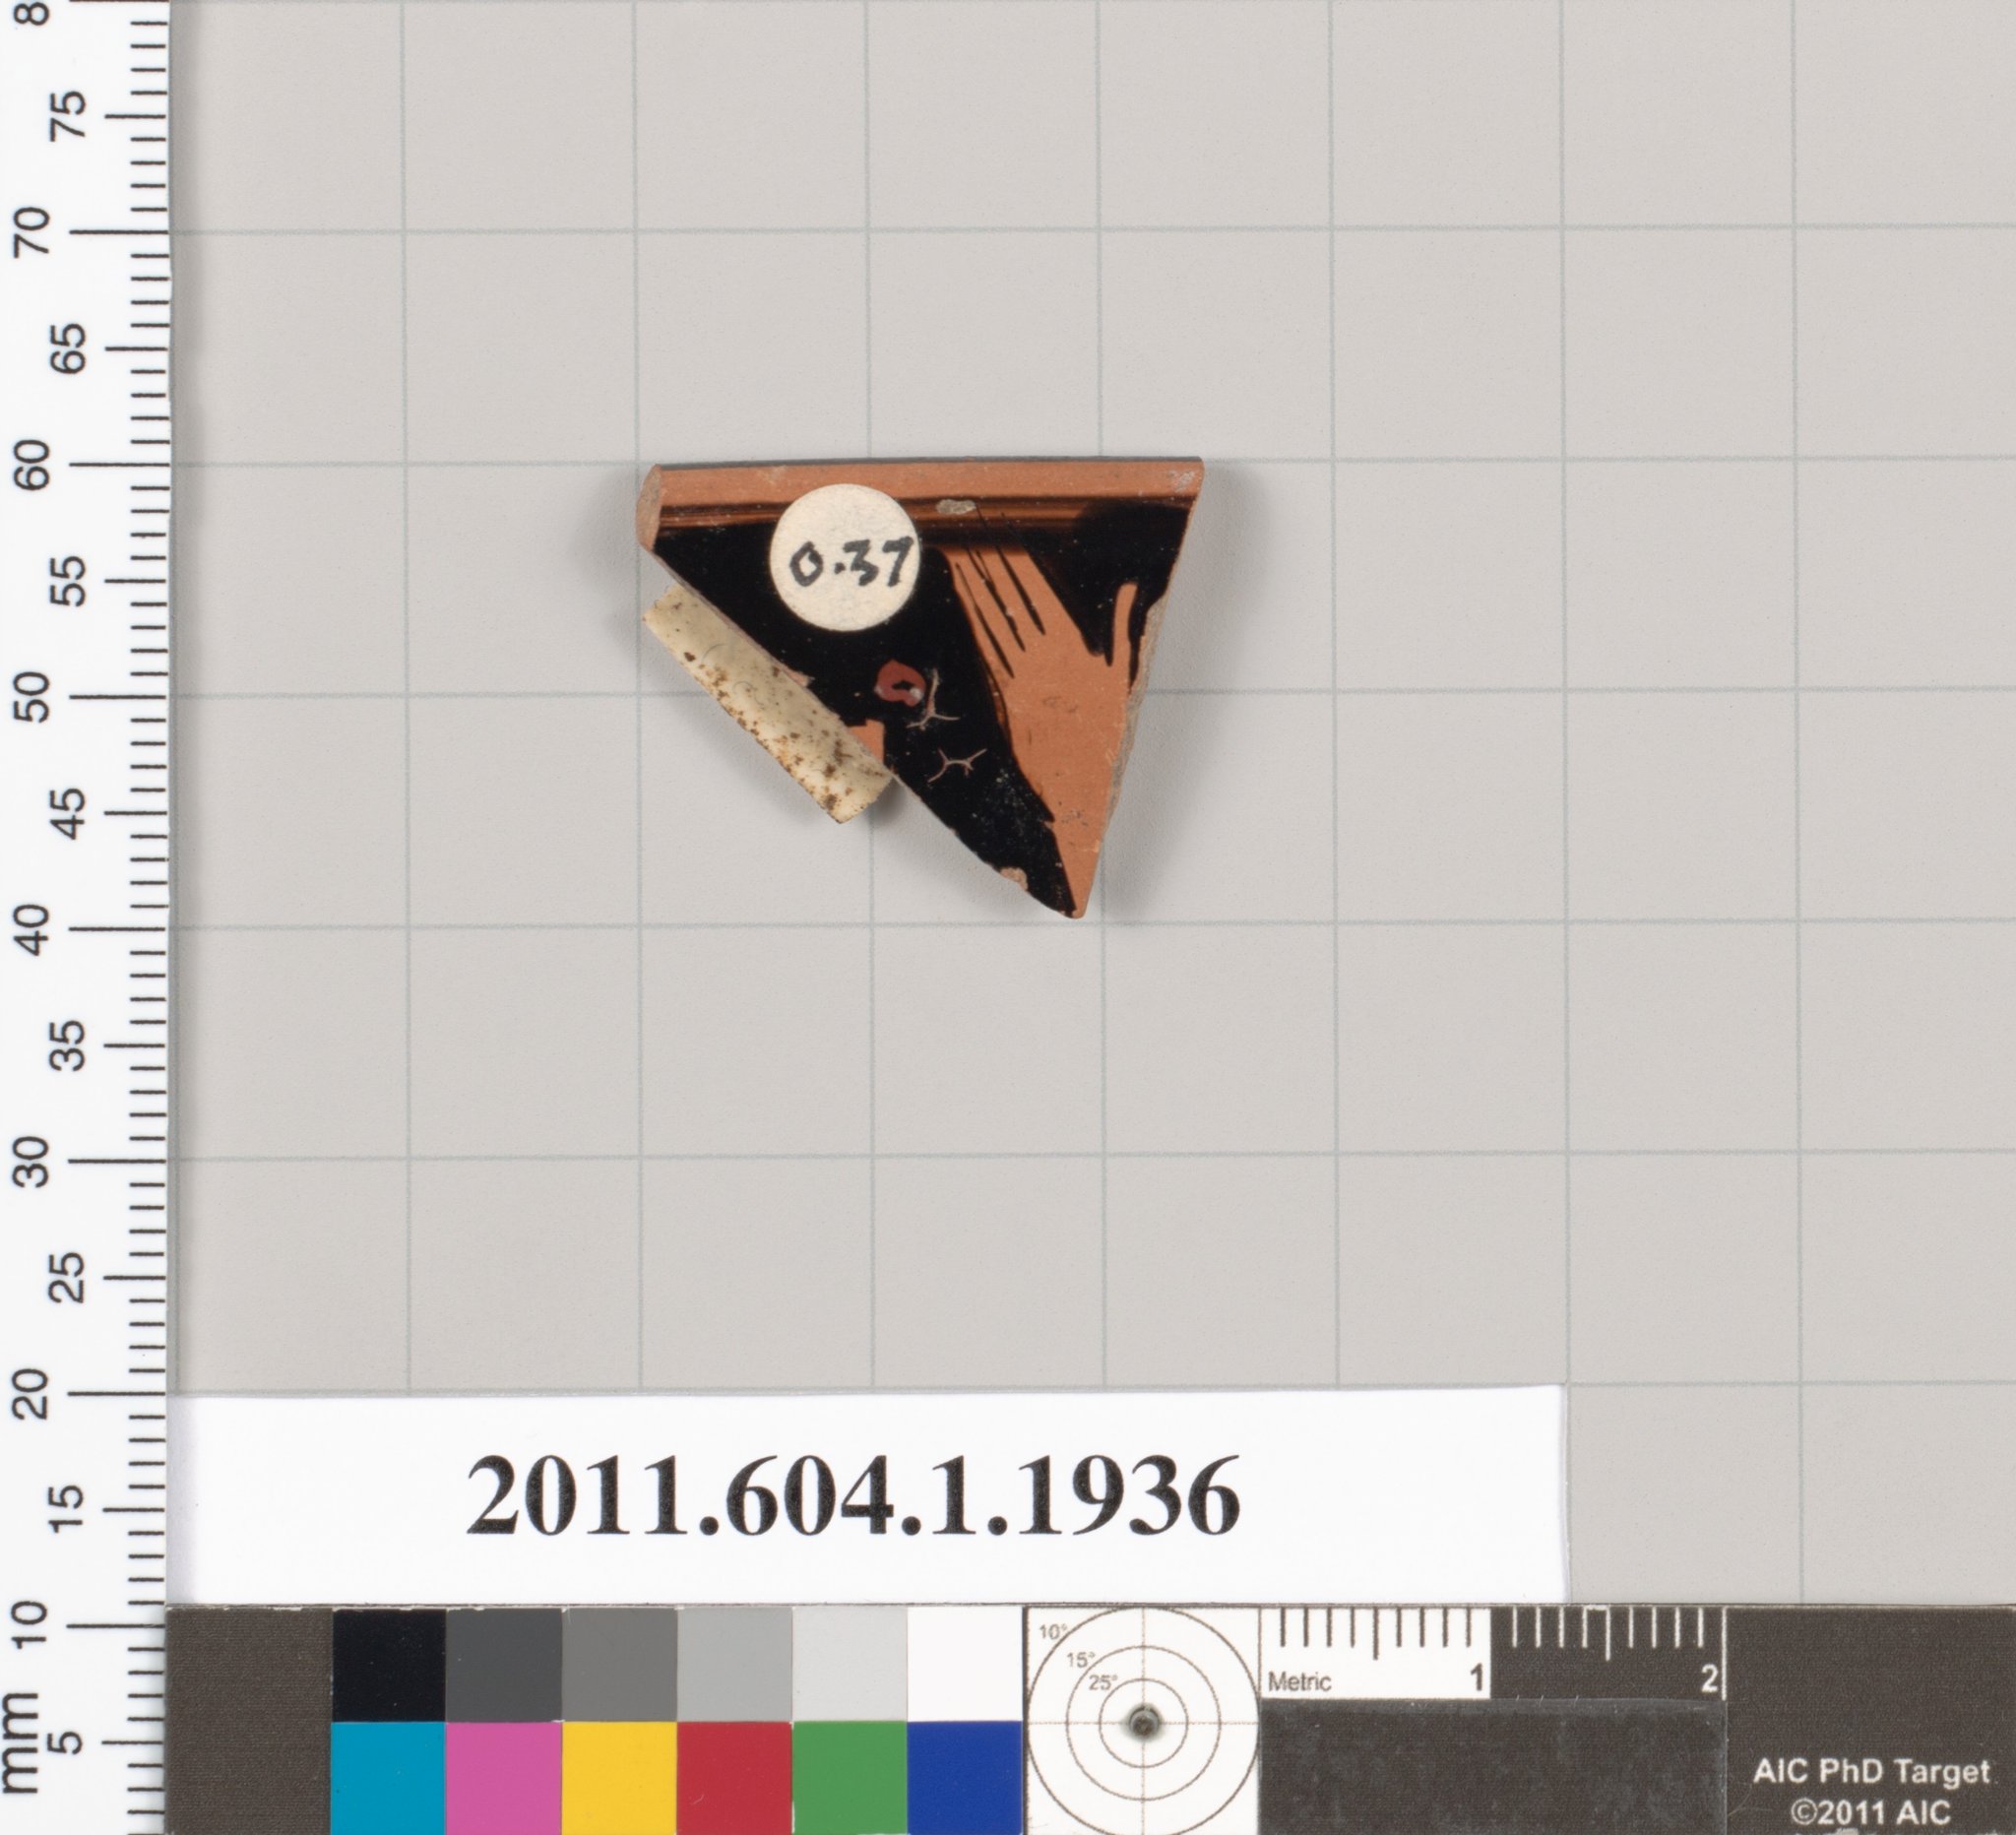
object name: kylix fragment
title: Terracotta rim fragment of a kylix (drinking cup)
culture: greek, attic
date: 500-476 BCE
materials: terracotta